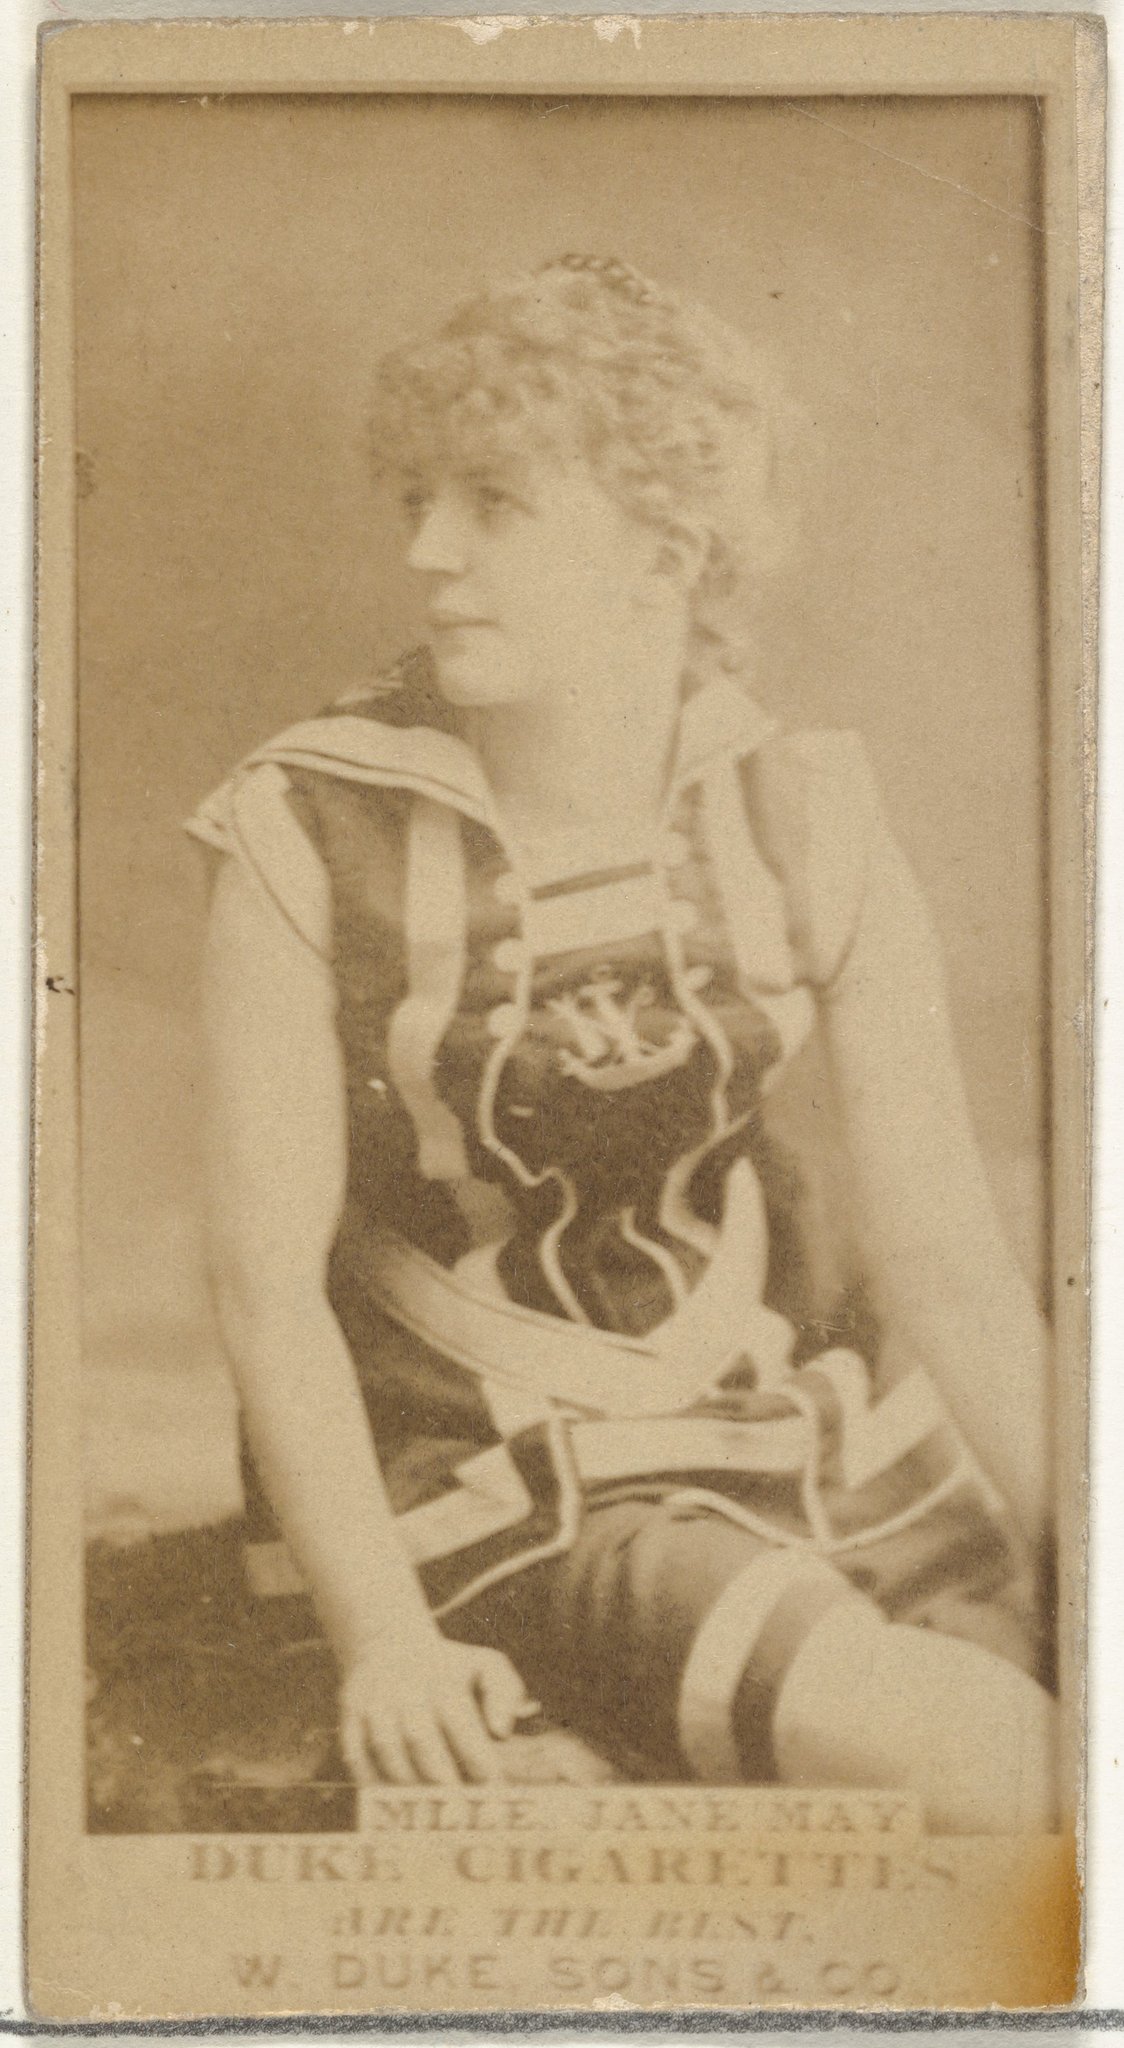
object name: photograph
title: Mlle. Jane May, from the Actors and Actresses series (N145-7) issued by Duke Sons & Co. to promote Duke Cigarettes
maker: w. duke, sons & co.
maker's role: publisher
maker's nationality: american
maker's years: 1870-1920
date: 1880-1889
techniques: albumen silver print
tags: portraits,women,actresses